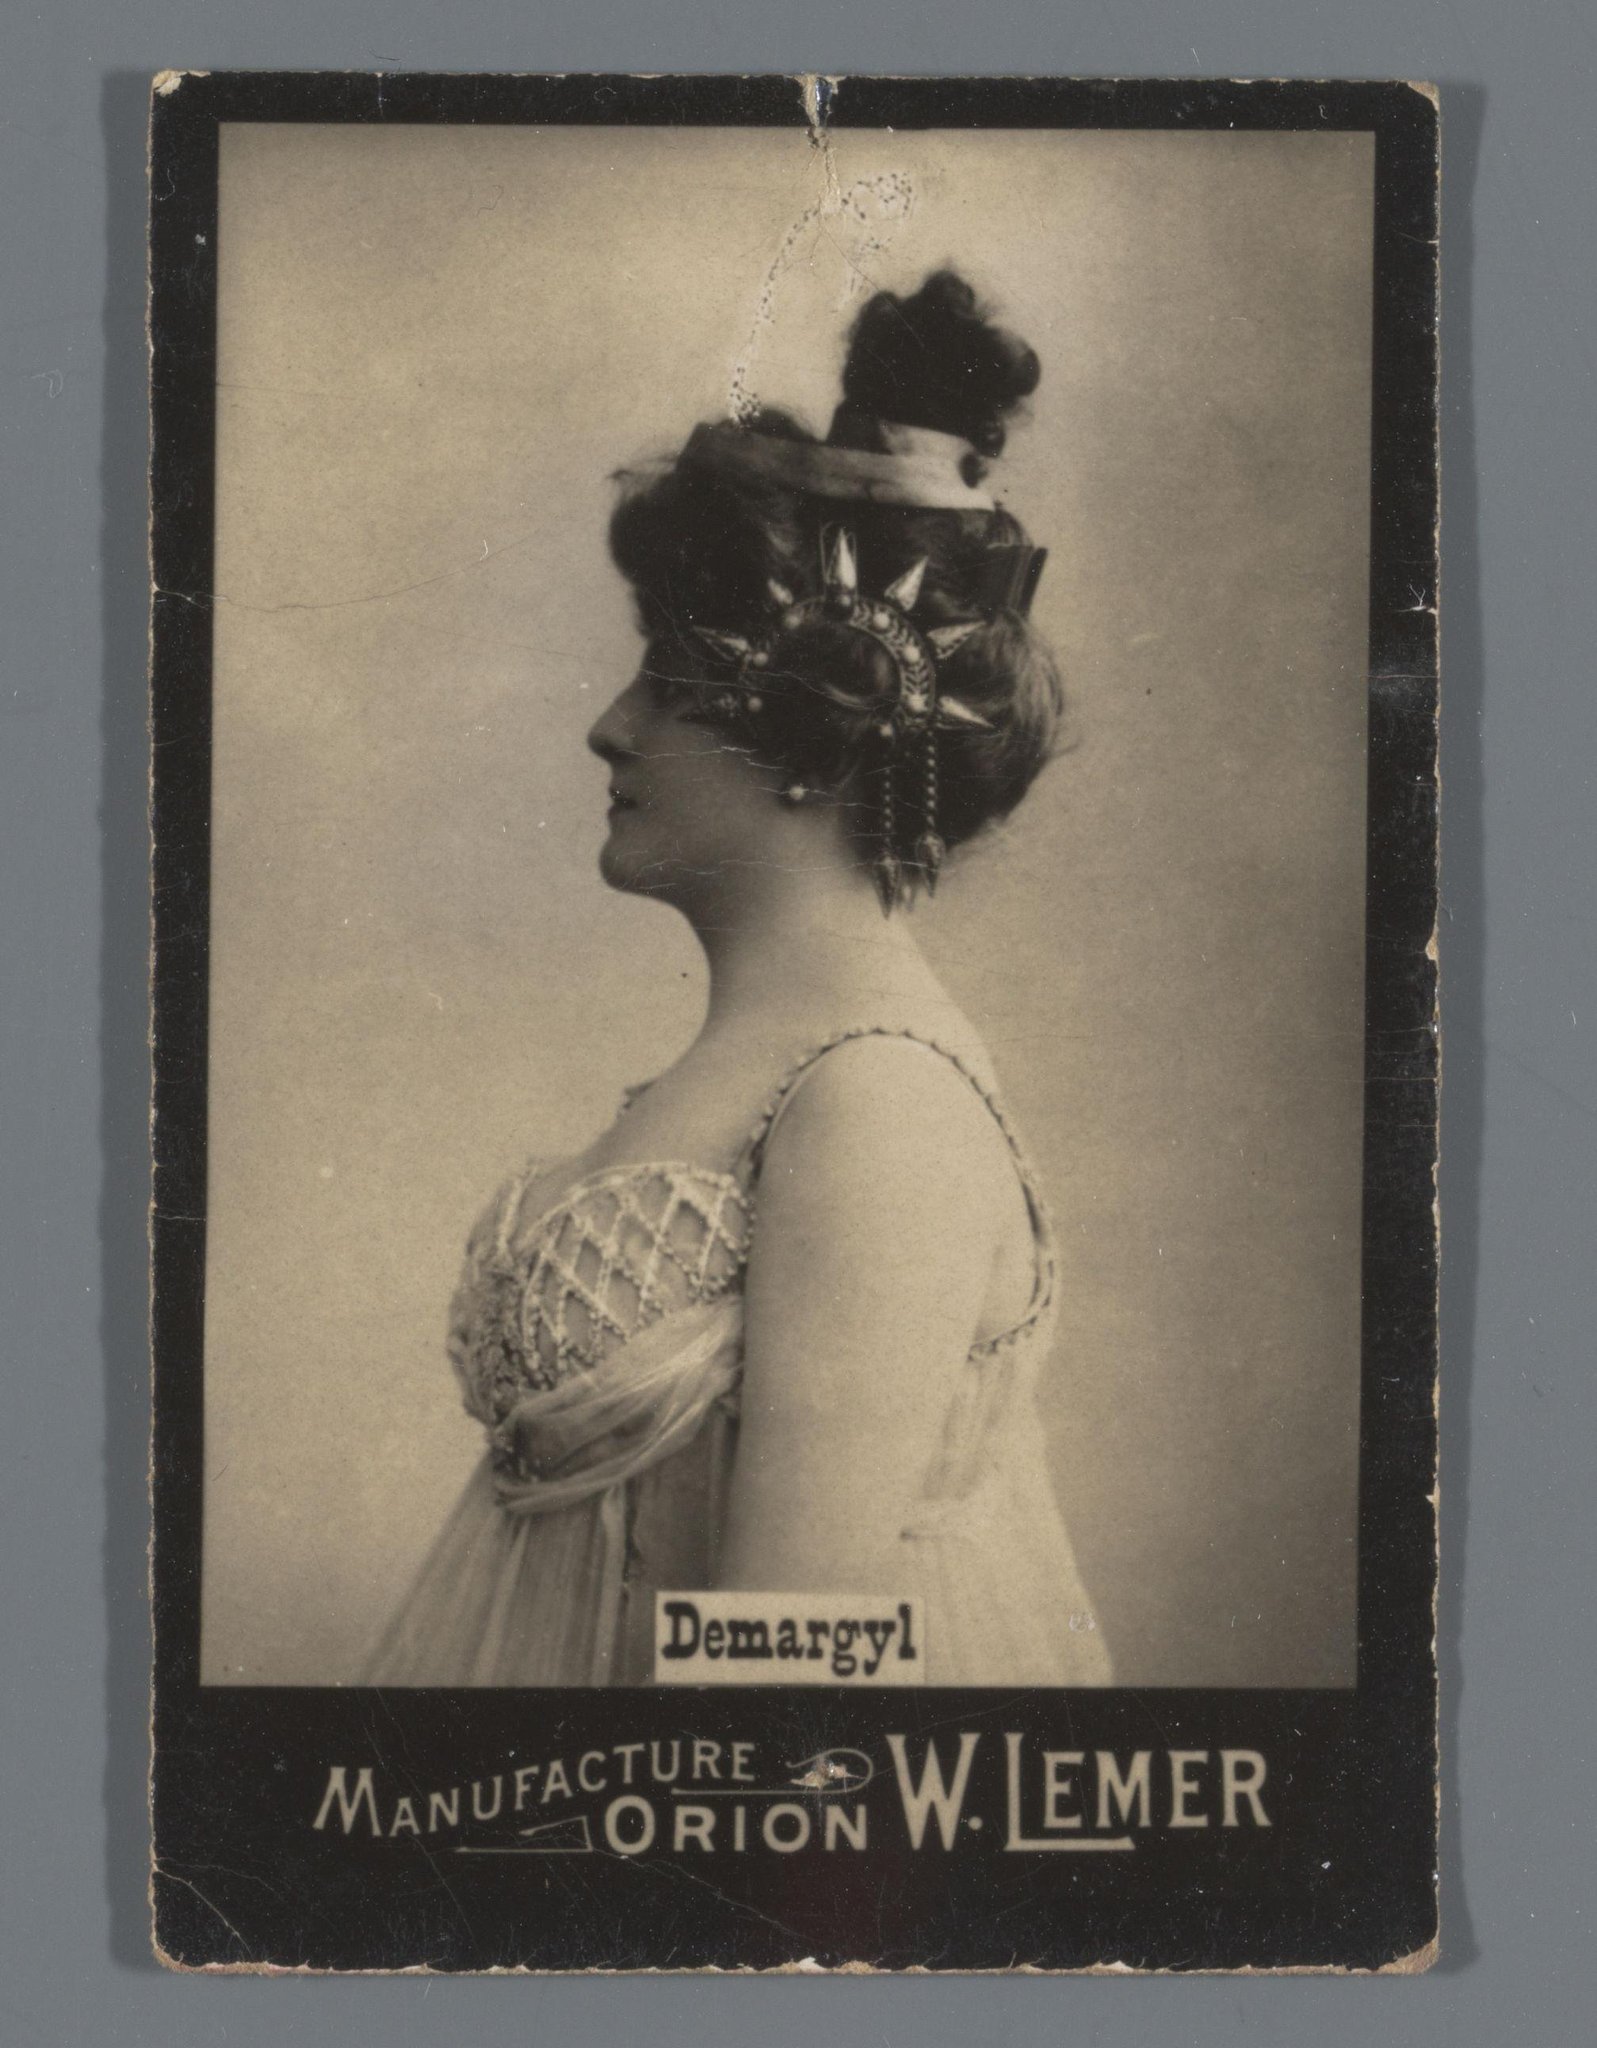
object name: photograph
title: Demargyl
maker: Anonymous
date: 1895-1910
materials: paper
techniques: gelatin silver print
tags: adult woman, anonymous historical person portrayed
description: Dergelijke foto's stonden bekend als 'zwartjes'. Men verkreeg ze bij aanschaf van bepaalde merken thee, cacao, sigaretten, beschuit, etc. om te verzamelen. Er waren speciaal voor de 'zwartjes' verzamelalbums in omloop.